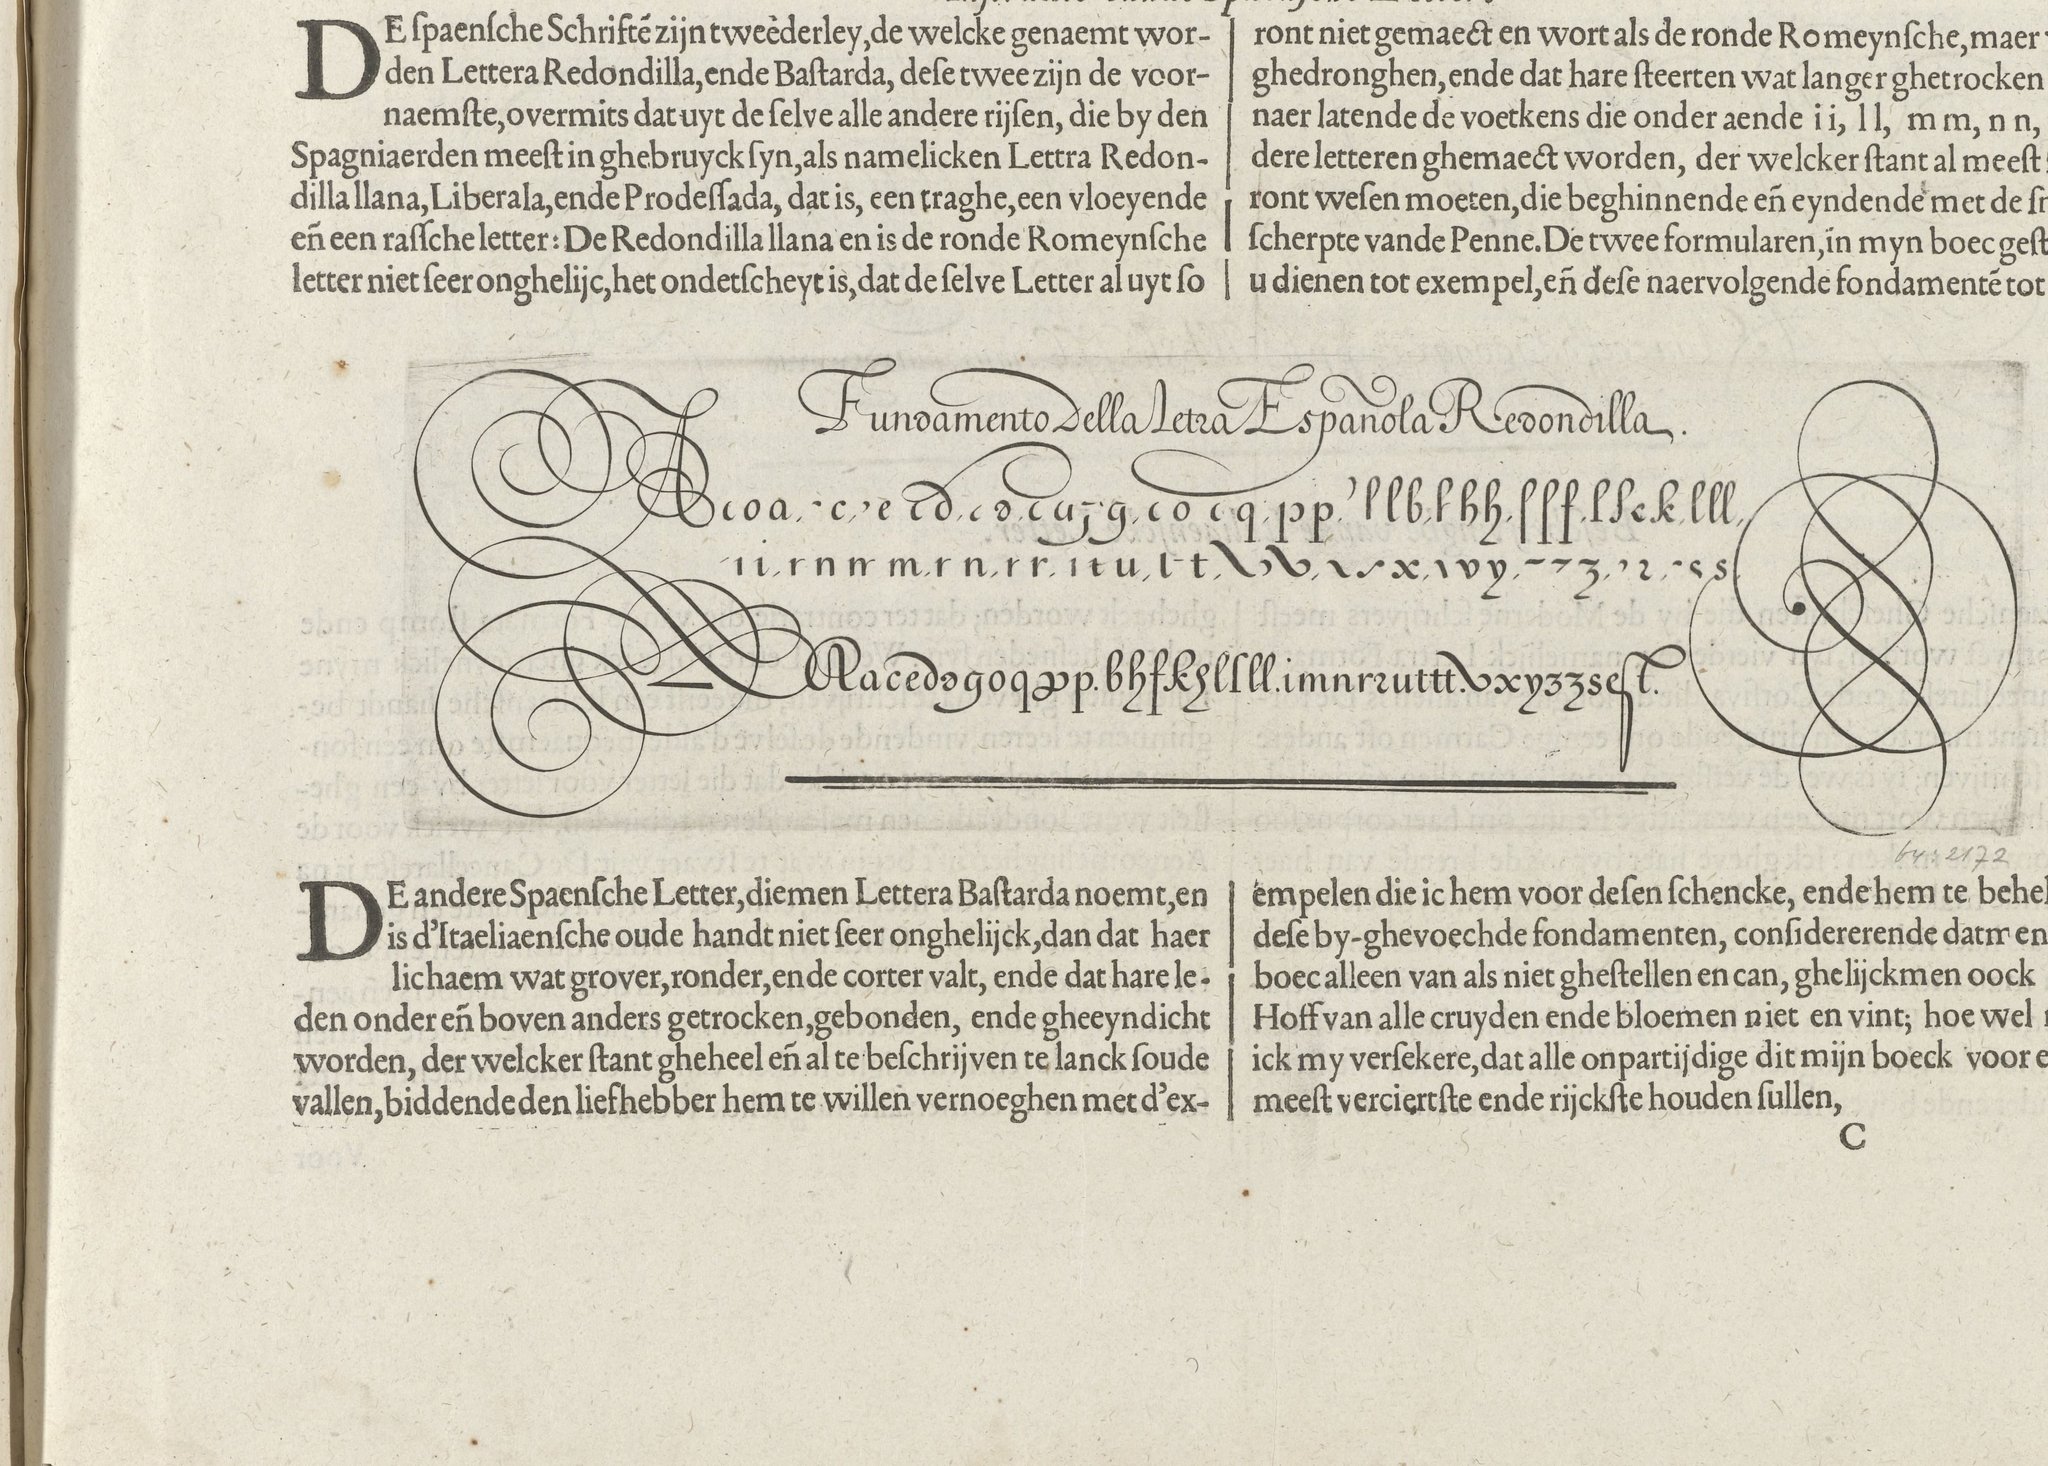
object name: print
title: Instructie vande Spaensche Letter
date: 1605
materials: paper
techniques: engraving, letterpress printing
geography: amsterdam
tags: calligraphy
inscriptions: collector's mark: Lugt 2228, collector's mark: Lugt 2760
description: Folio C1r met een instructie van de Spaanse letter en een schrijfvoorbeeld getiteld: Fundamento della Letra Espanola Redondilla. Het blad maakt deel uit van een album.